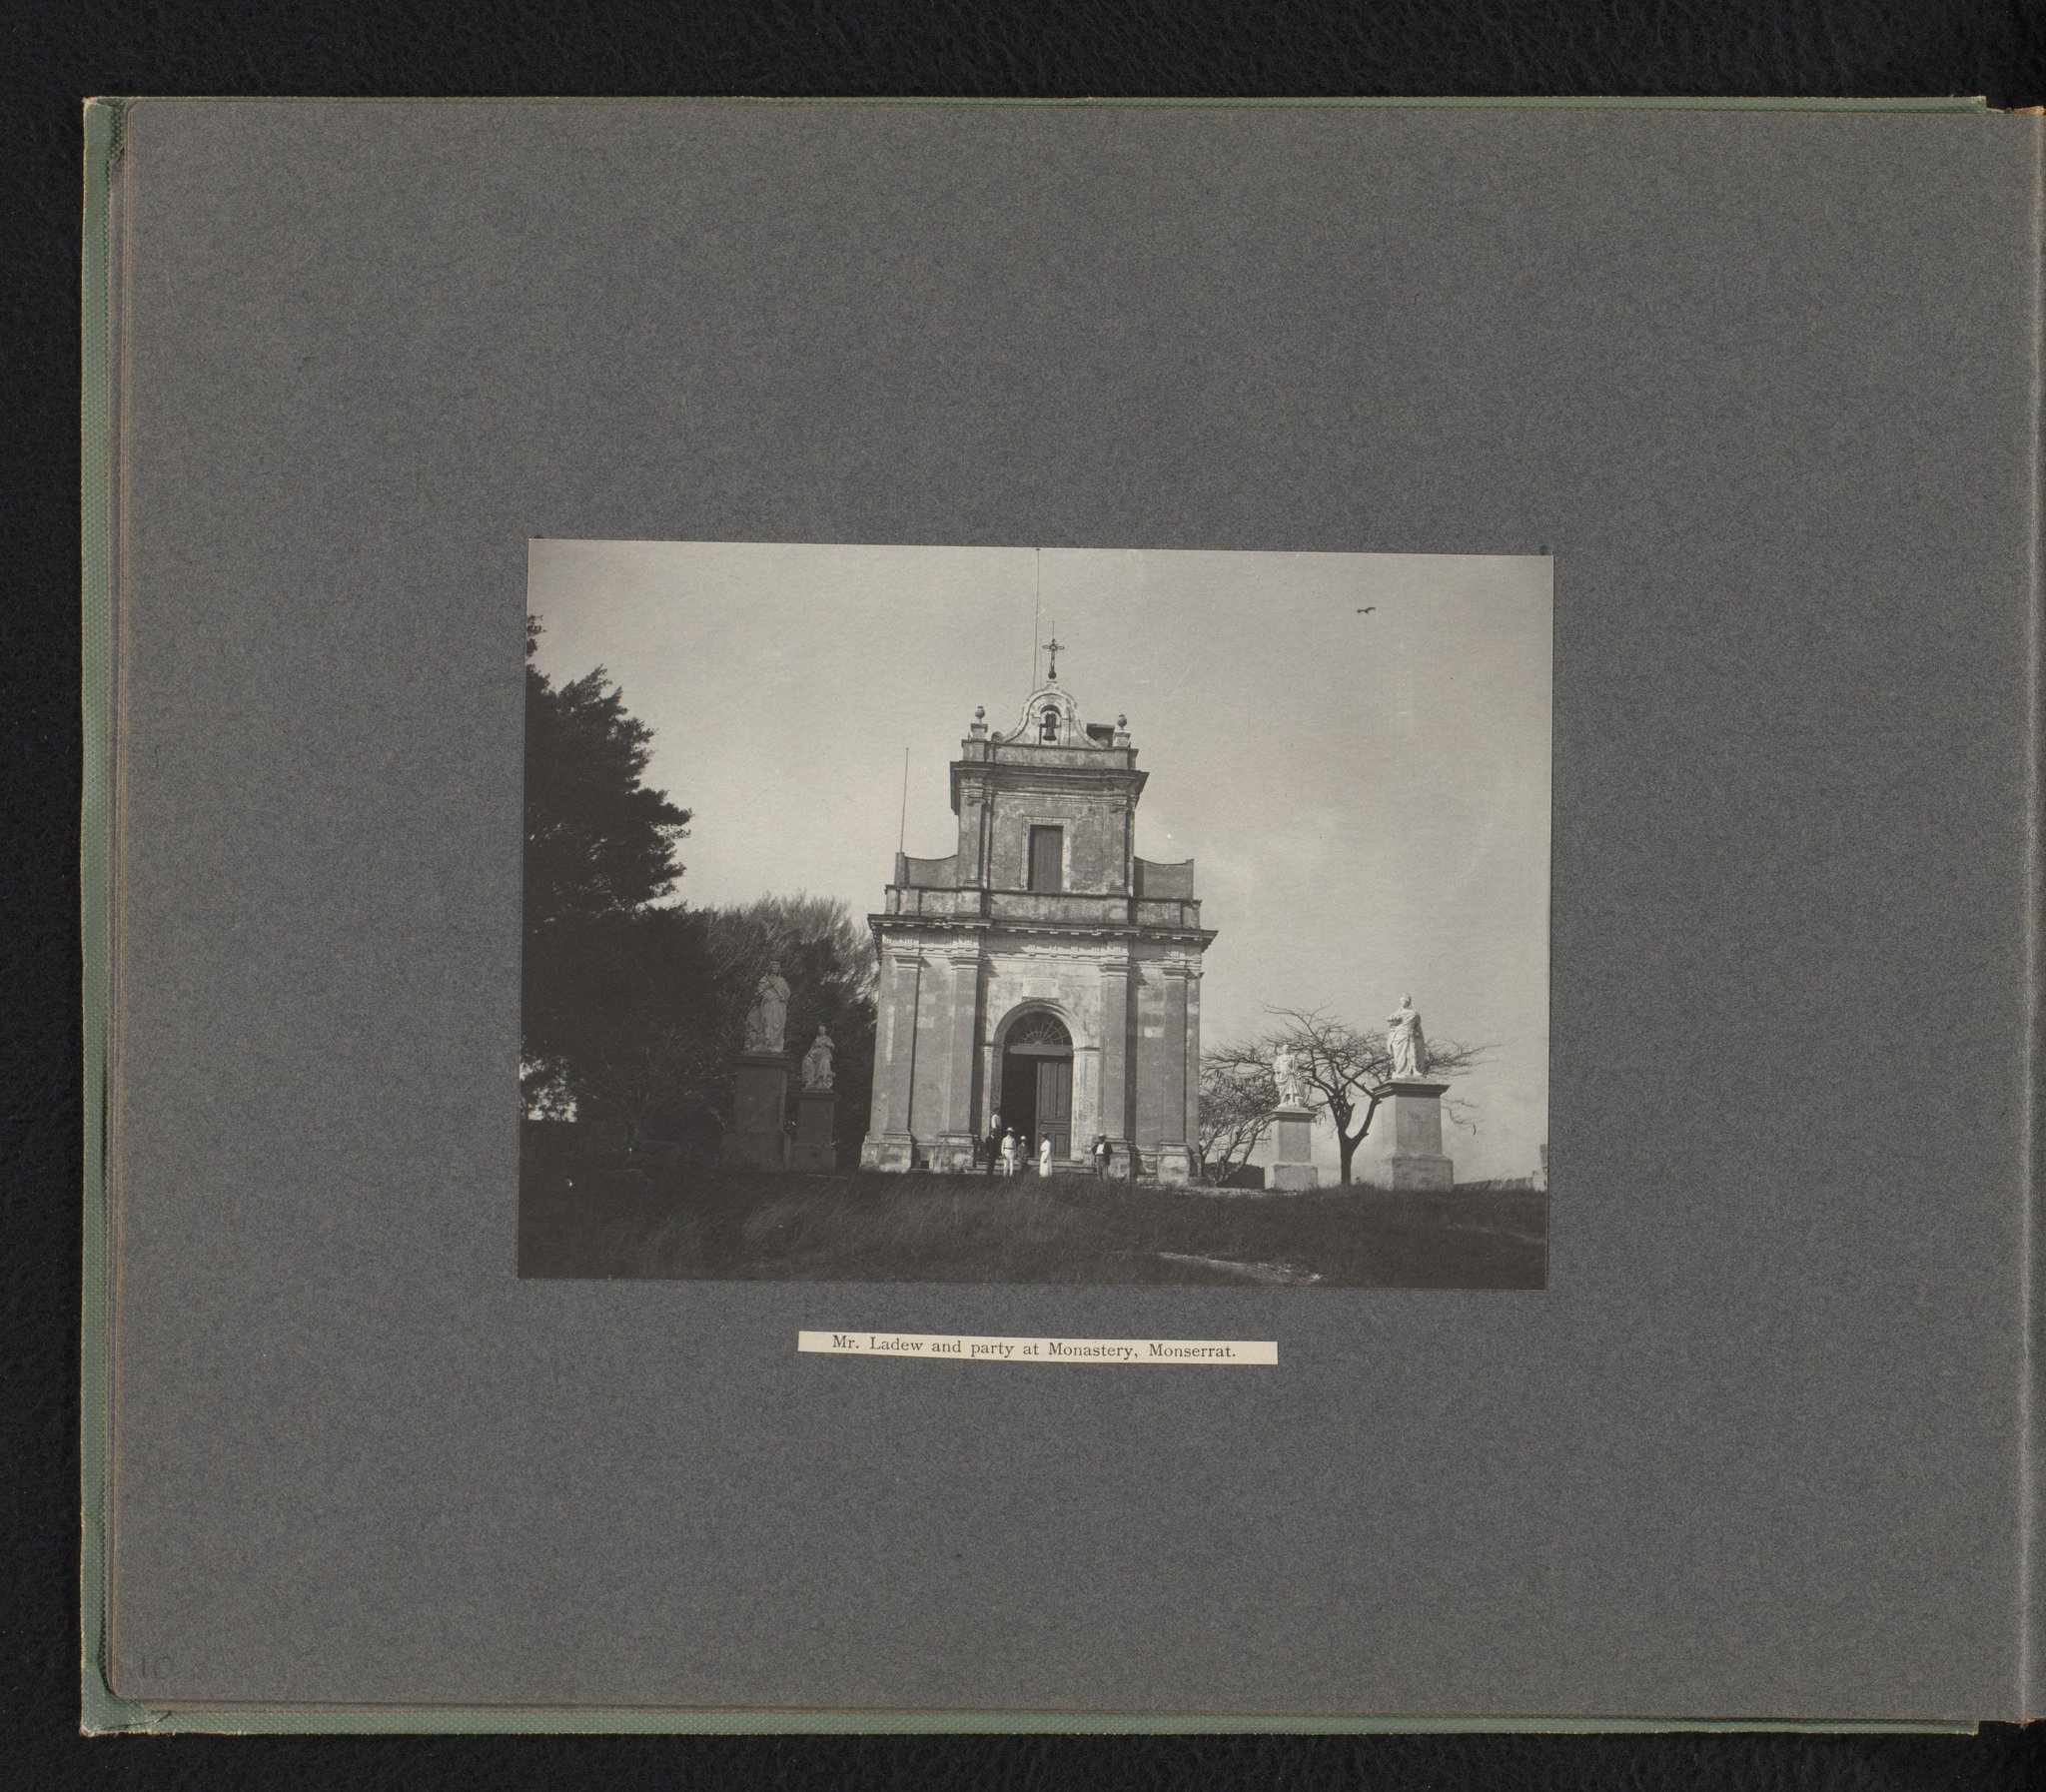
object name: album leaf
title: Joseph Harvey Ladew en zijn reisgezelschap voor de Ermita de Monserrate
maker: Anonymous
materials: paper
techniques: platinum process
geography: matanzas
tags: joseph harvey ladew sr., church (exterior)